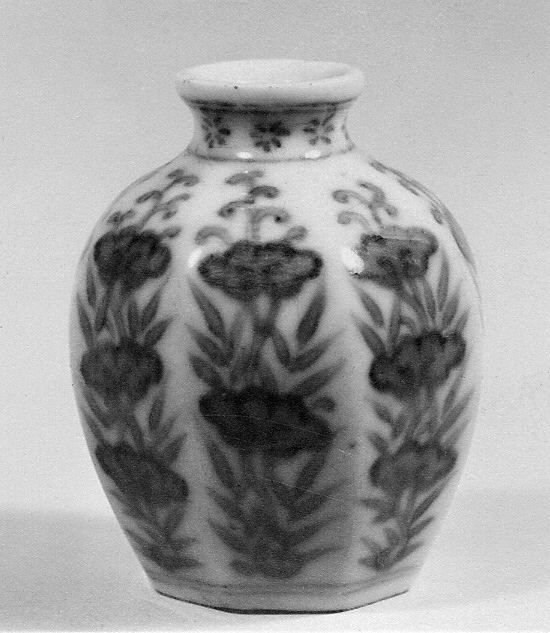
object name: snuff bottle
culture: chinese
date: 1723-1735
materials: porcelain